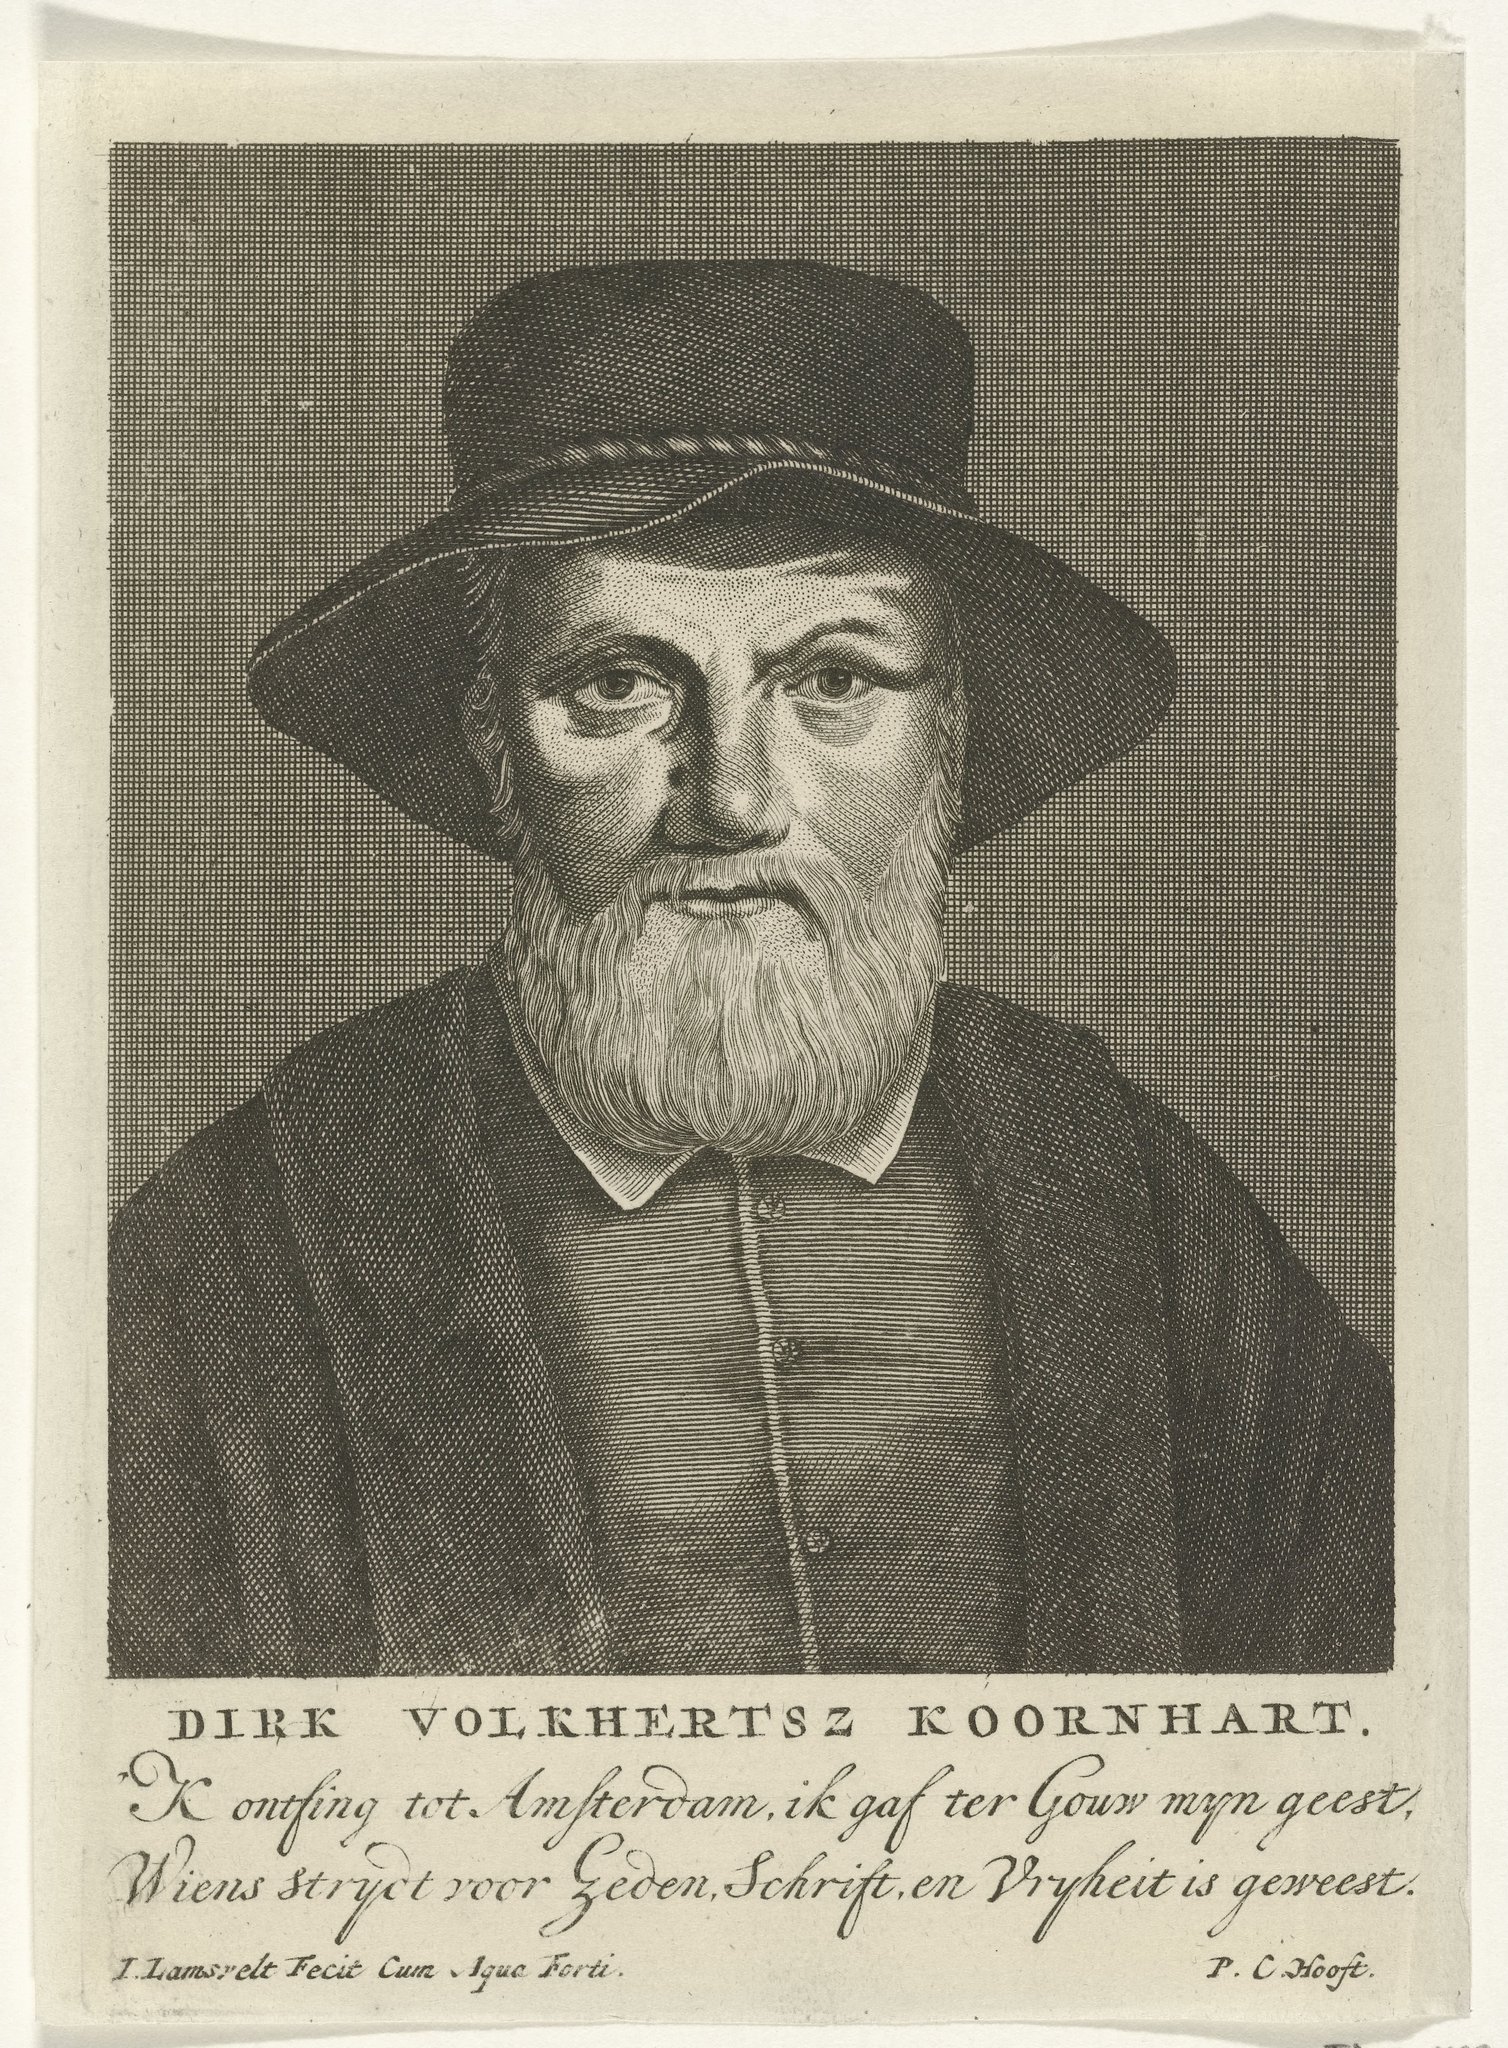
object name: print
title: Portret van Dirck Volckertsz. Coornhert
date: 1696-1743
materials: paper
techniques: engraving, etching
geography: amsterdam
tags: amsterdam, gouda, print maker, draughtsman, dirck volckertsz. coornhert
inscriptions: collector's mark: Lugt 2228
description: Prent ook gebruikt in: G. Brandts Historie der Reformatie, en andre kerkelyke geschiedenissen, in en ontrent de Nederlanden. Met eenige aantekeningen en aenmerkingen, Naerder oversien, merkelijk vermeerdert, en vervolgt tot het jaer 1600 [Het eerste deel]. 2e druk [moet een latere druk zijn]. Amsterdam: Jan Rieuwertsz. en Hendrik en Dirk Boom [?], 1677 [in of na 1696], tussen p. 768 en 769.* *Hoewel op de titelpagina deze uitgevers worden genoemd en het jaartal 1677 staat vermeld als jaar van uitgave, kan dit niet kloppen. Deze uitgave heeft weliswaar tevens exact dezelfde titel als de werkelijke tweede druk uit 1677, maar is typografisch anders en bevat andere prenten. Alle prenten zijn van de hand van Jan Lamsvelt (werkzame periode: 1696-1743), waardoor het geheel in of na 1696 te dateren valt.